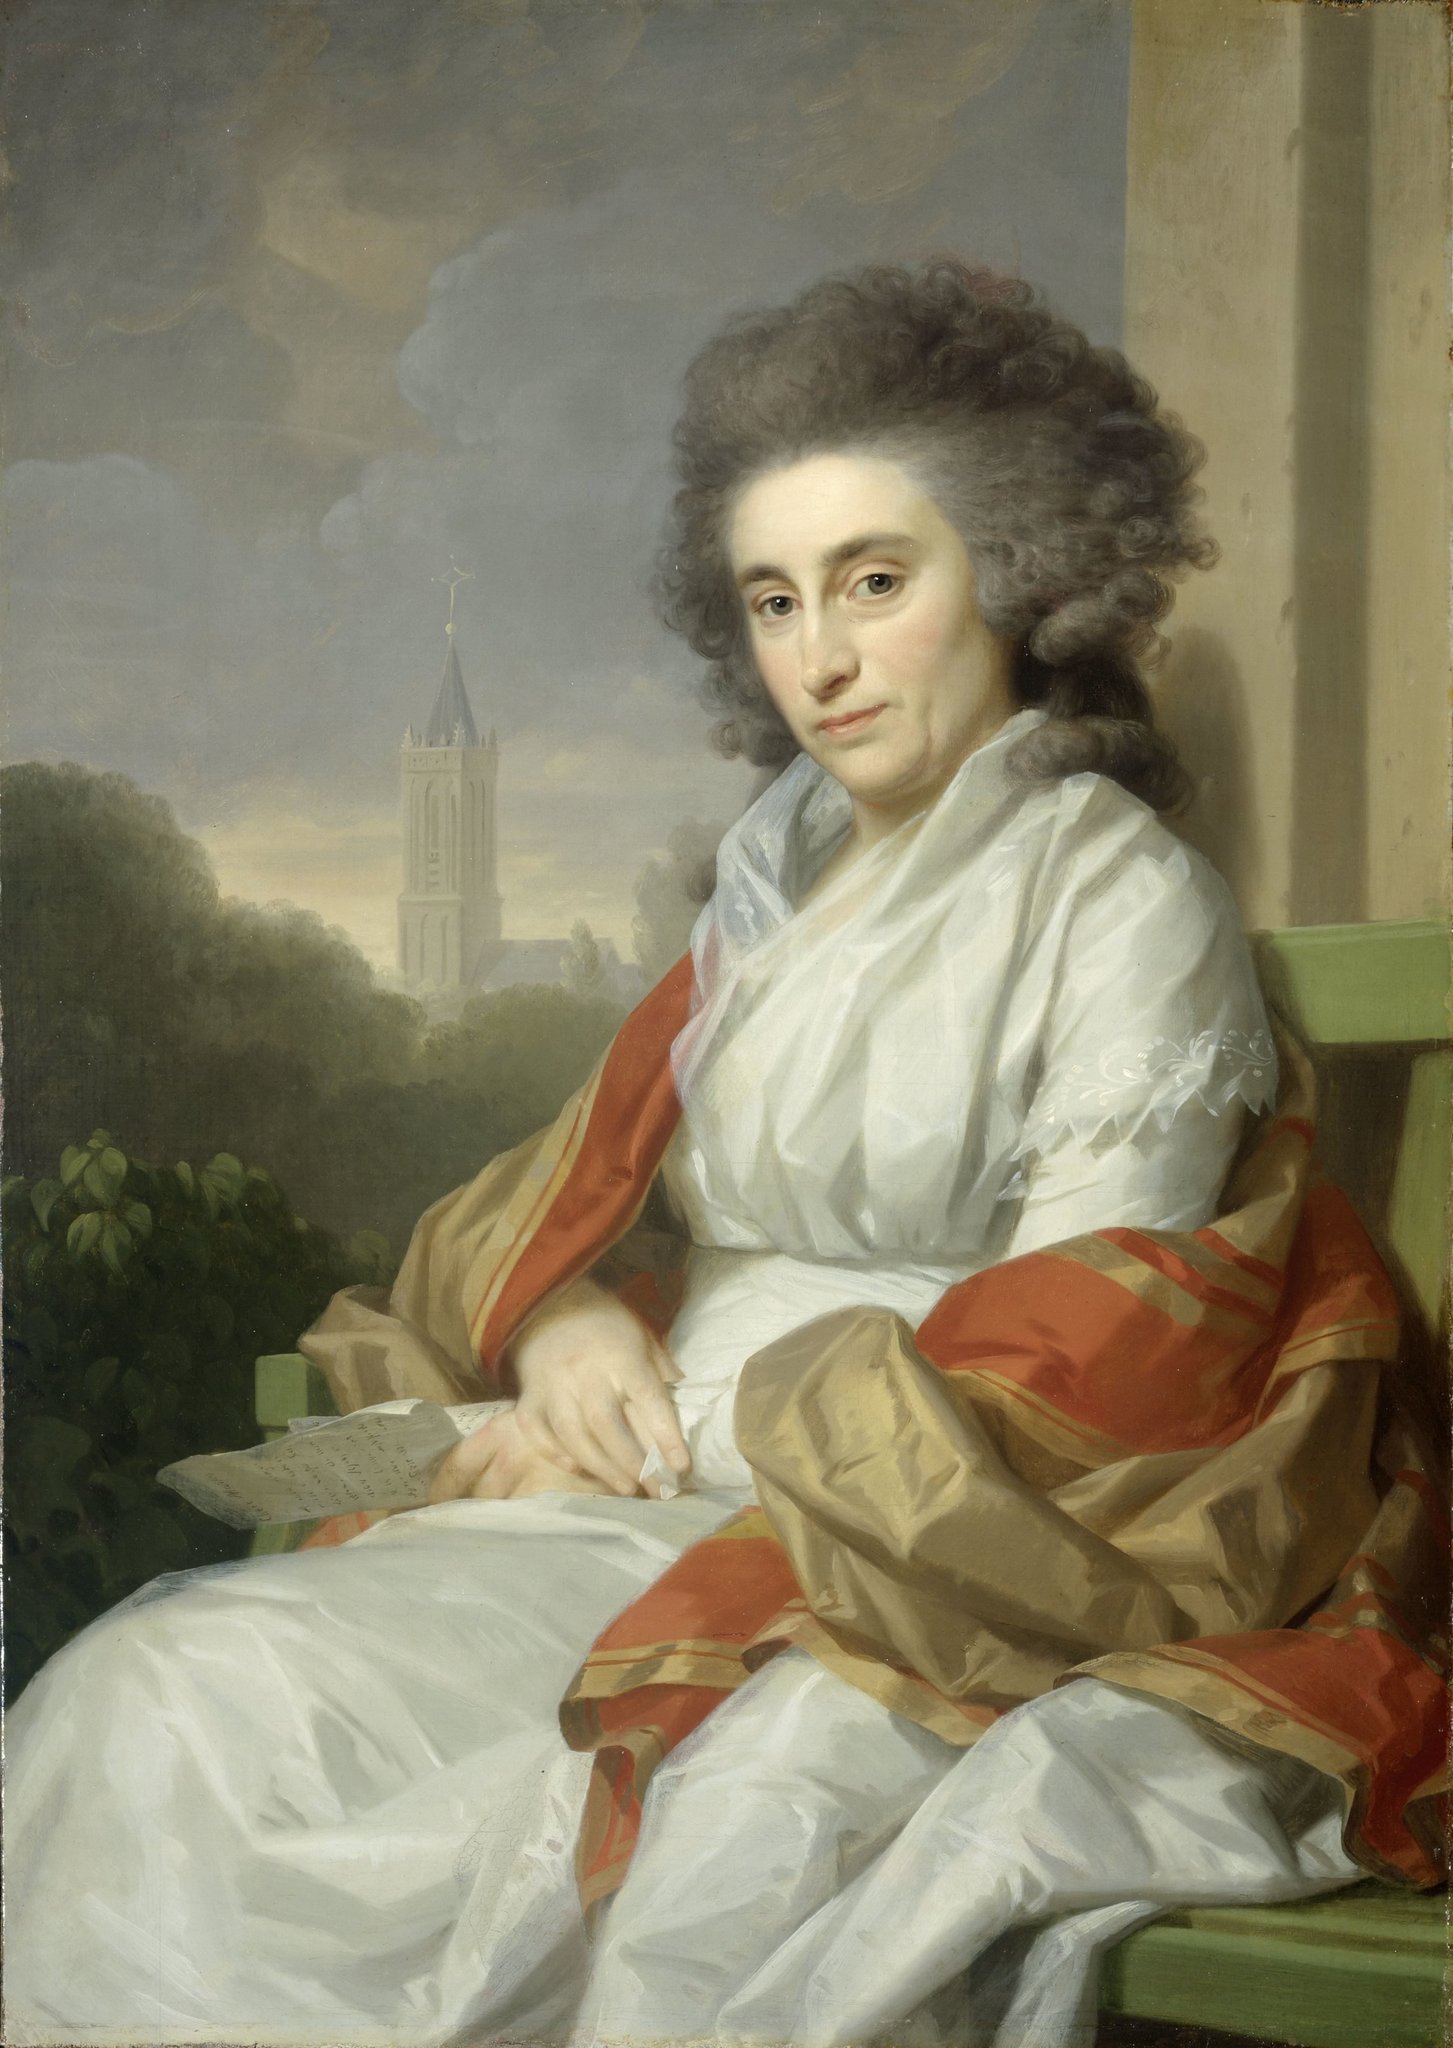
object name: painting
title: Portrait of Cornelia Rijdenius, Wife of Johannes Lublink II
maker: johann friedrich august tischbein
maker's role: painter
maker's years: 1750-1812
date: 1790-1795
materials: canvas, oil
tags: historical persons - bb - woman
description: Portret van Cornelia Rijdenius (1746-1826), echtgenote van Johannes Lublink. Kniestuk, zittend op een terras met een brief in de hand, in de verte bomen en een kerktoren. Pendant van SK-A-2827.